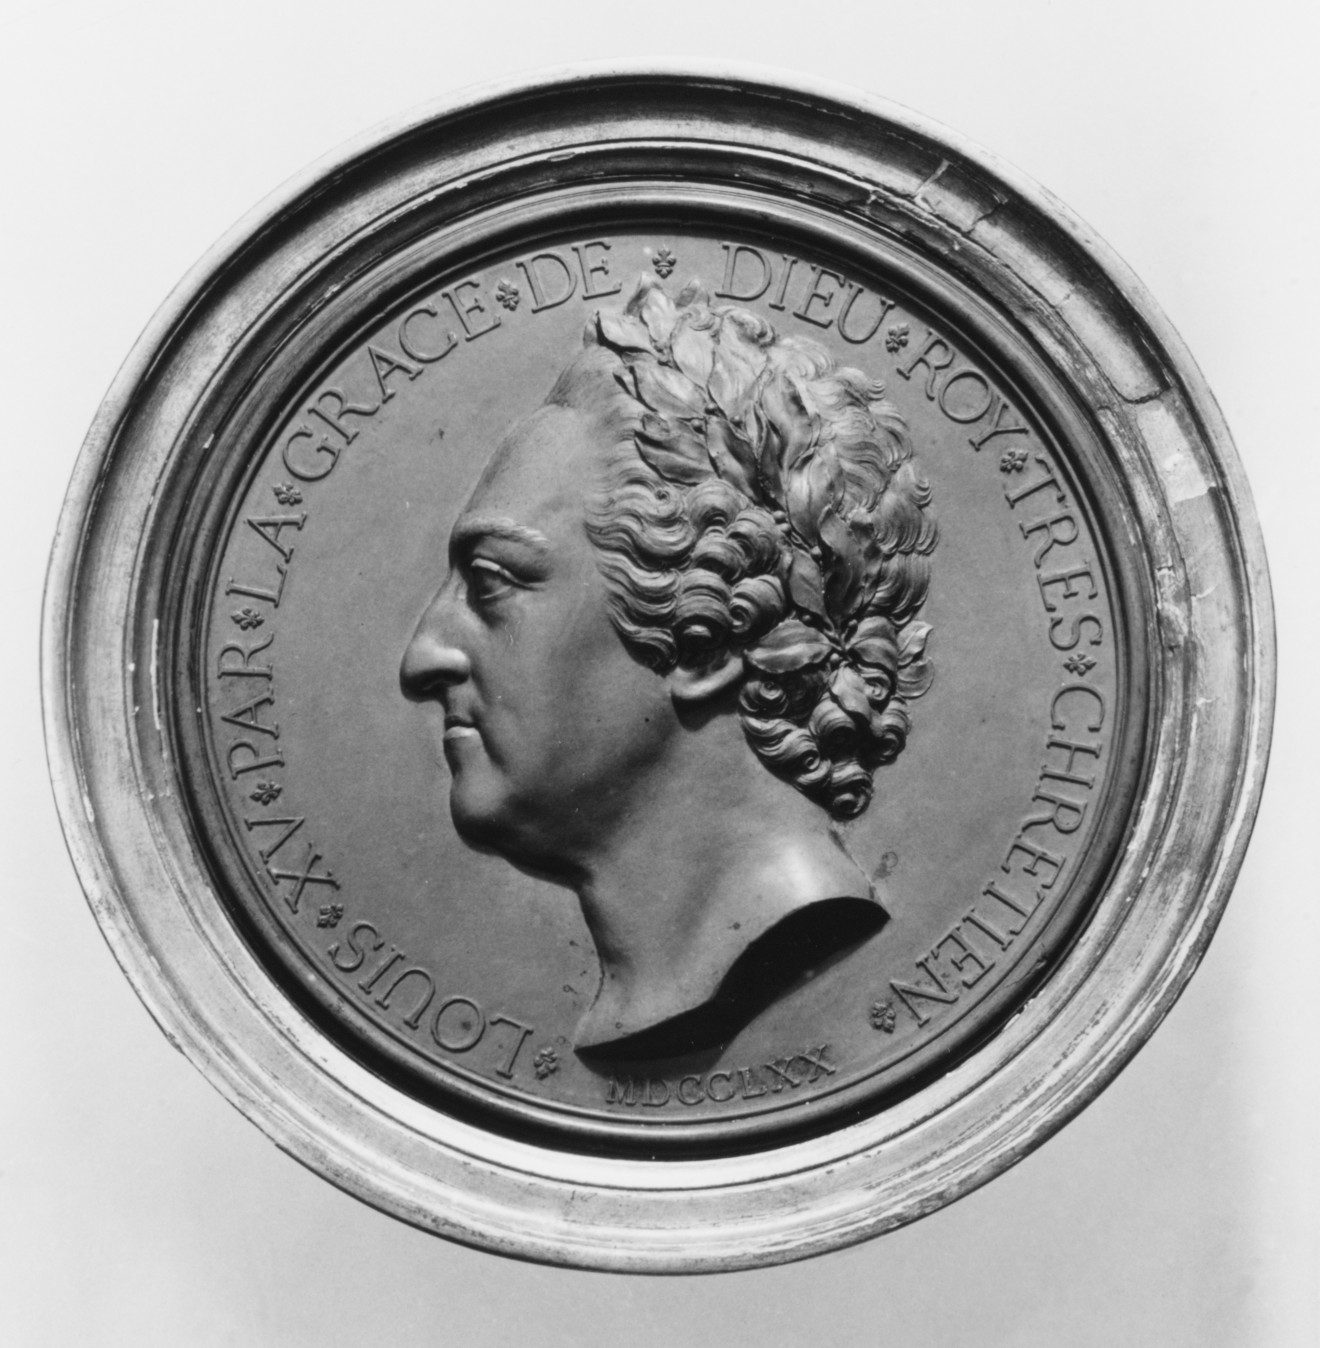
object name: medallion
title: Louis XV (1710–1774)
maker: jean-baptiste nini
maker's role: artist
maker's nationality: italian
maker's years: 1717-1786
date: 1770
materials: gilt, terracotta, wood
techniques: casting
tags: kings,profiles